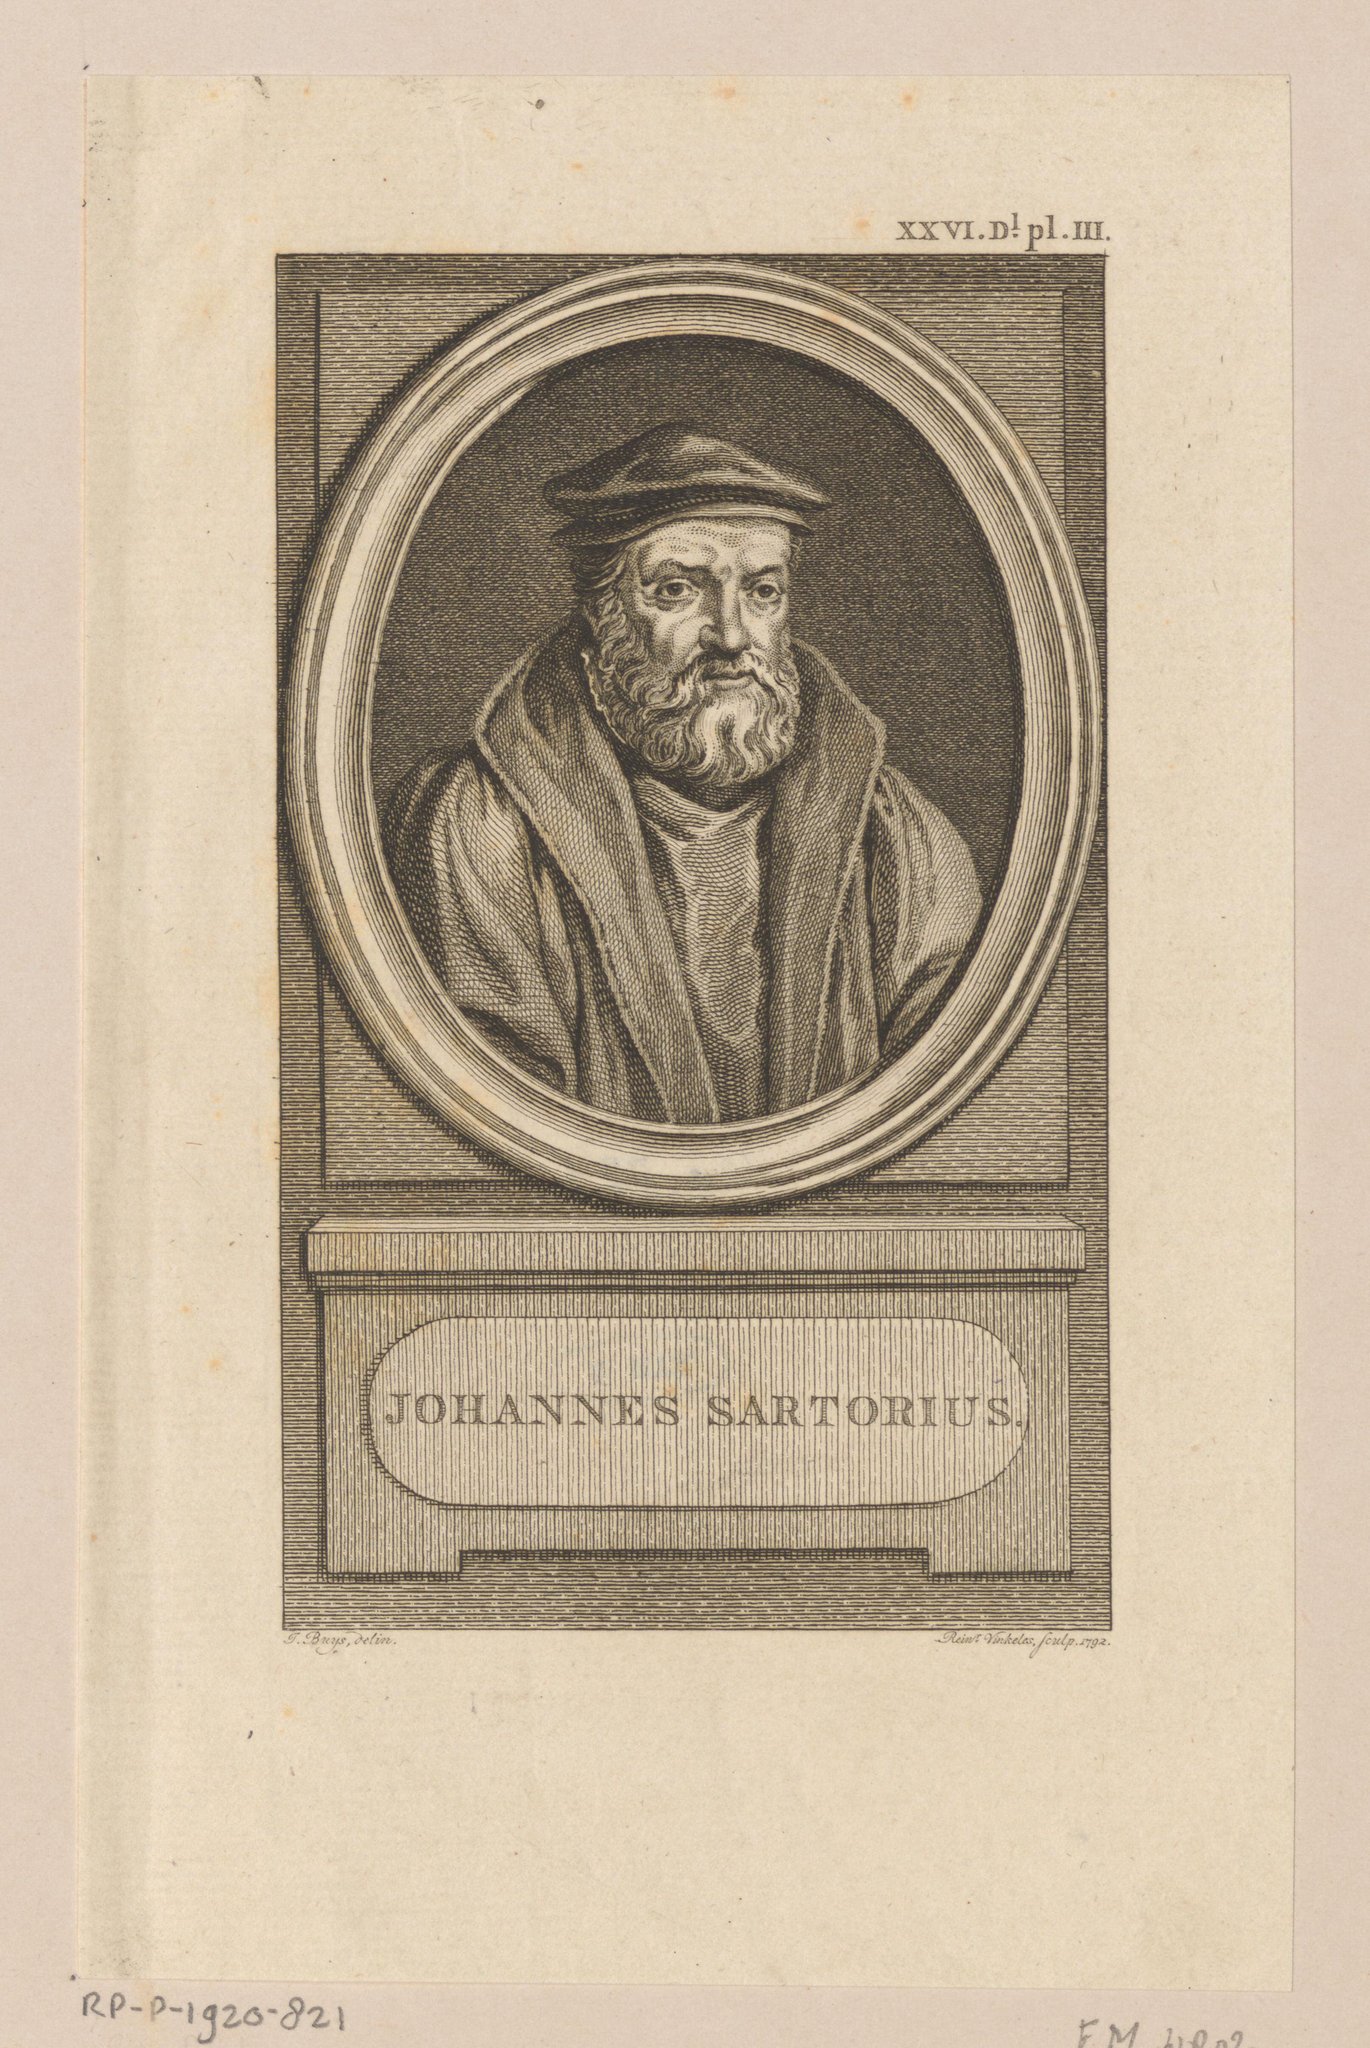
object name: print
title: Portret van Johannes Sartorius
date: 1792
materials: paper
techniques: engraving, etching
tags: amsterdam, delft, johannes sartorius, theologian, historical persons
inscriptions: collector's mark: Lugt 2228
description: Prent waarschijnlijk uit: Kok, Jacobus. Vaderlandsch woordenboek (...). Amsterdam: Johannes Allart, 1792, dl. 26.